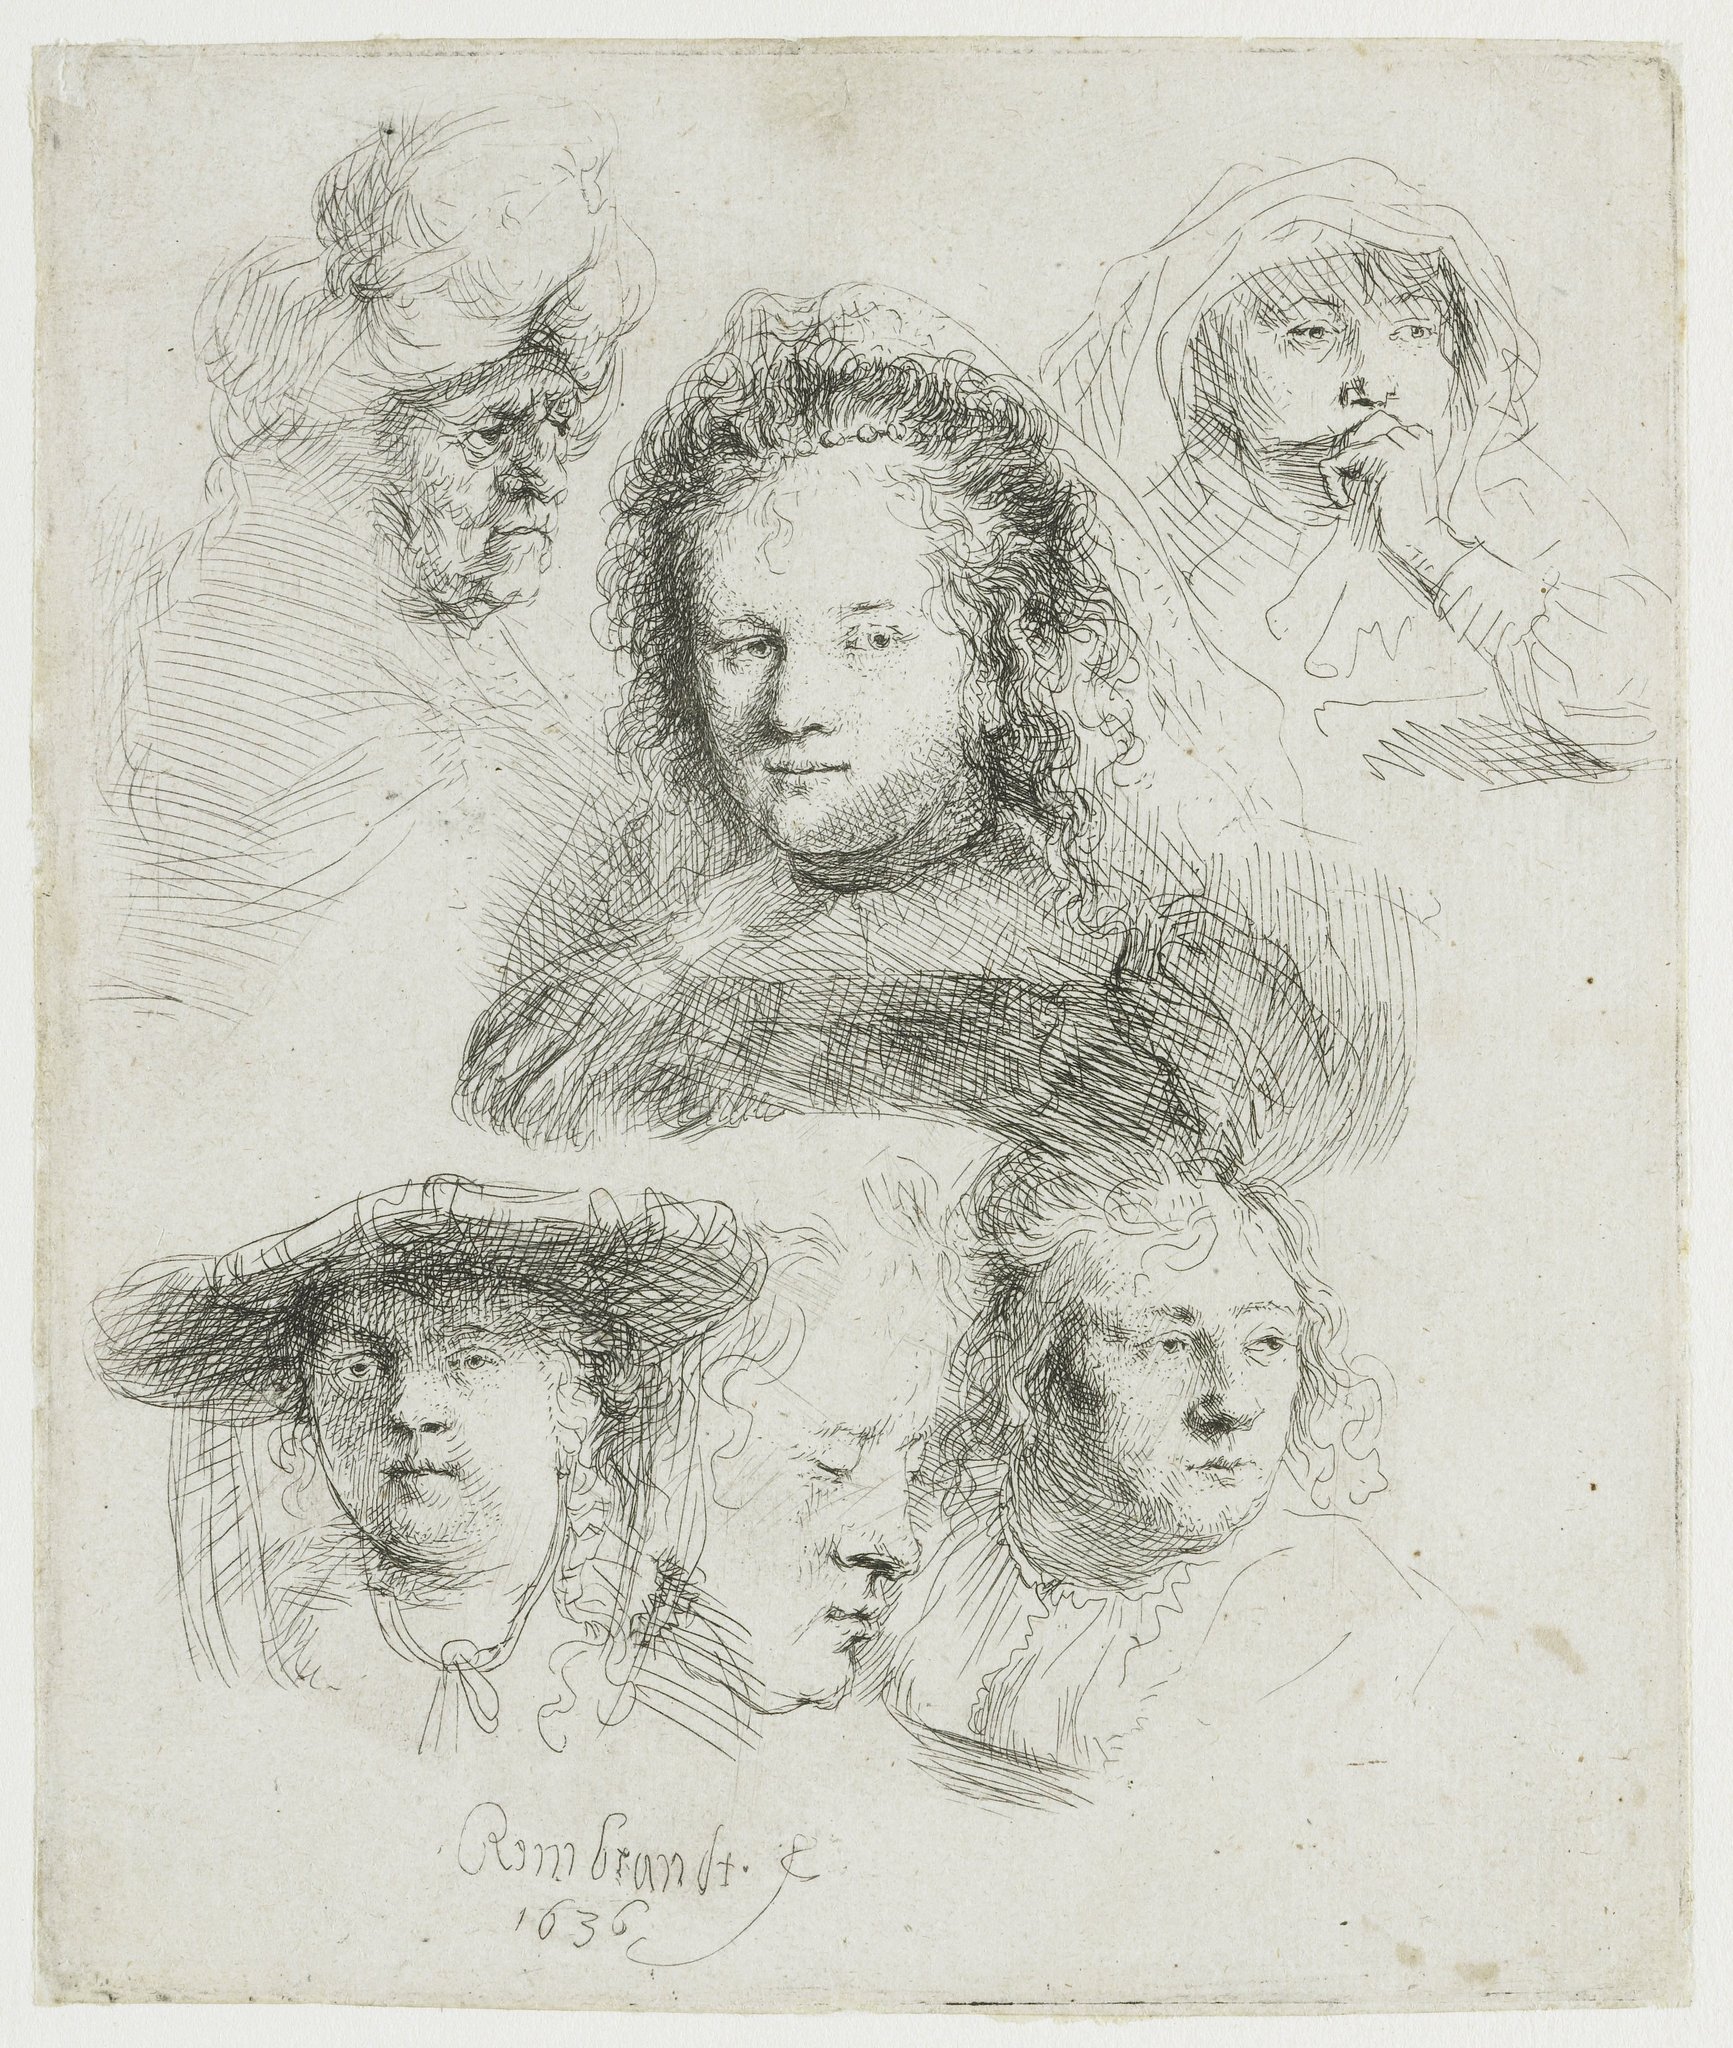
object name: print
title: Studies of the head of Saskia and others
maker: rembrandt van rijn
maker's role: draughtsman, painter, print maker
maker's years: 1606-1669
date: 1636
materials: paper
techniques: etching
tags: amsterdam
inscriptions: signature and date: ‘Rembrandt. f 1636’, collector's mark: Lugt 240